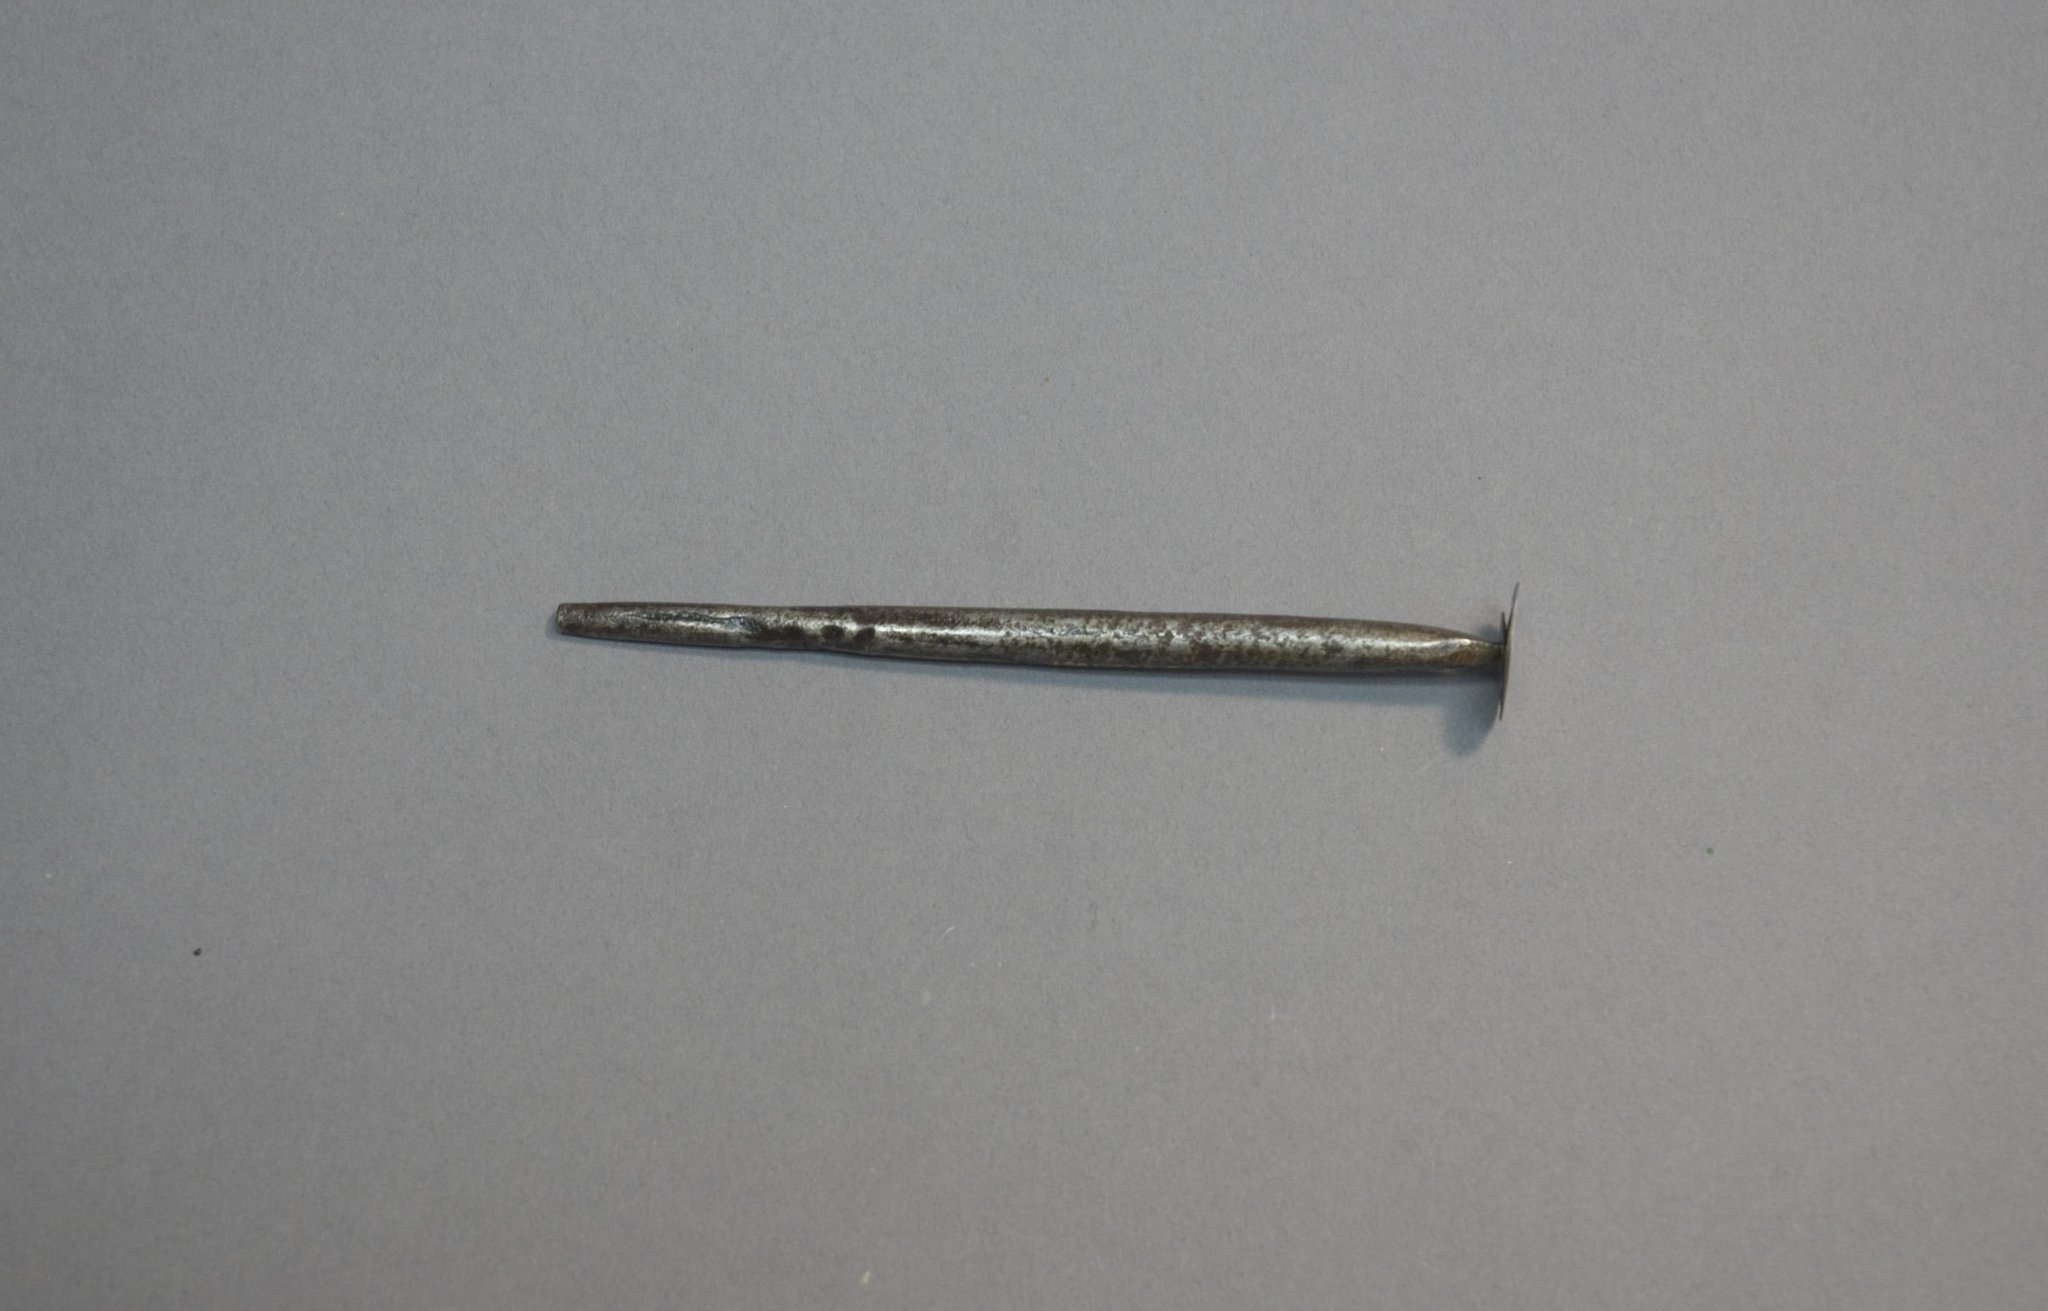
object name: jade carving tool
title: Small engraving wheel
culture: chinese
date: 1901-2000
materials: steel